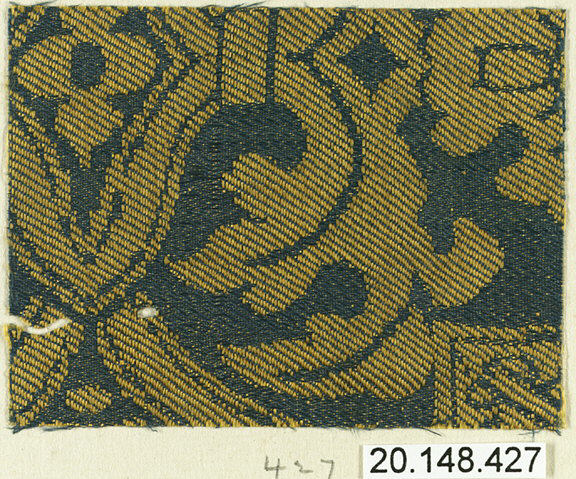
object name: piece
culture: japanese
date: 1701-1800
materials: silk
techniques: compound weave